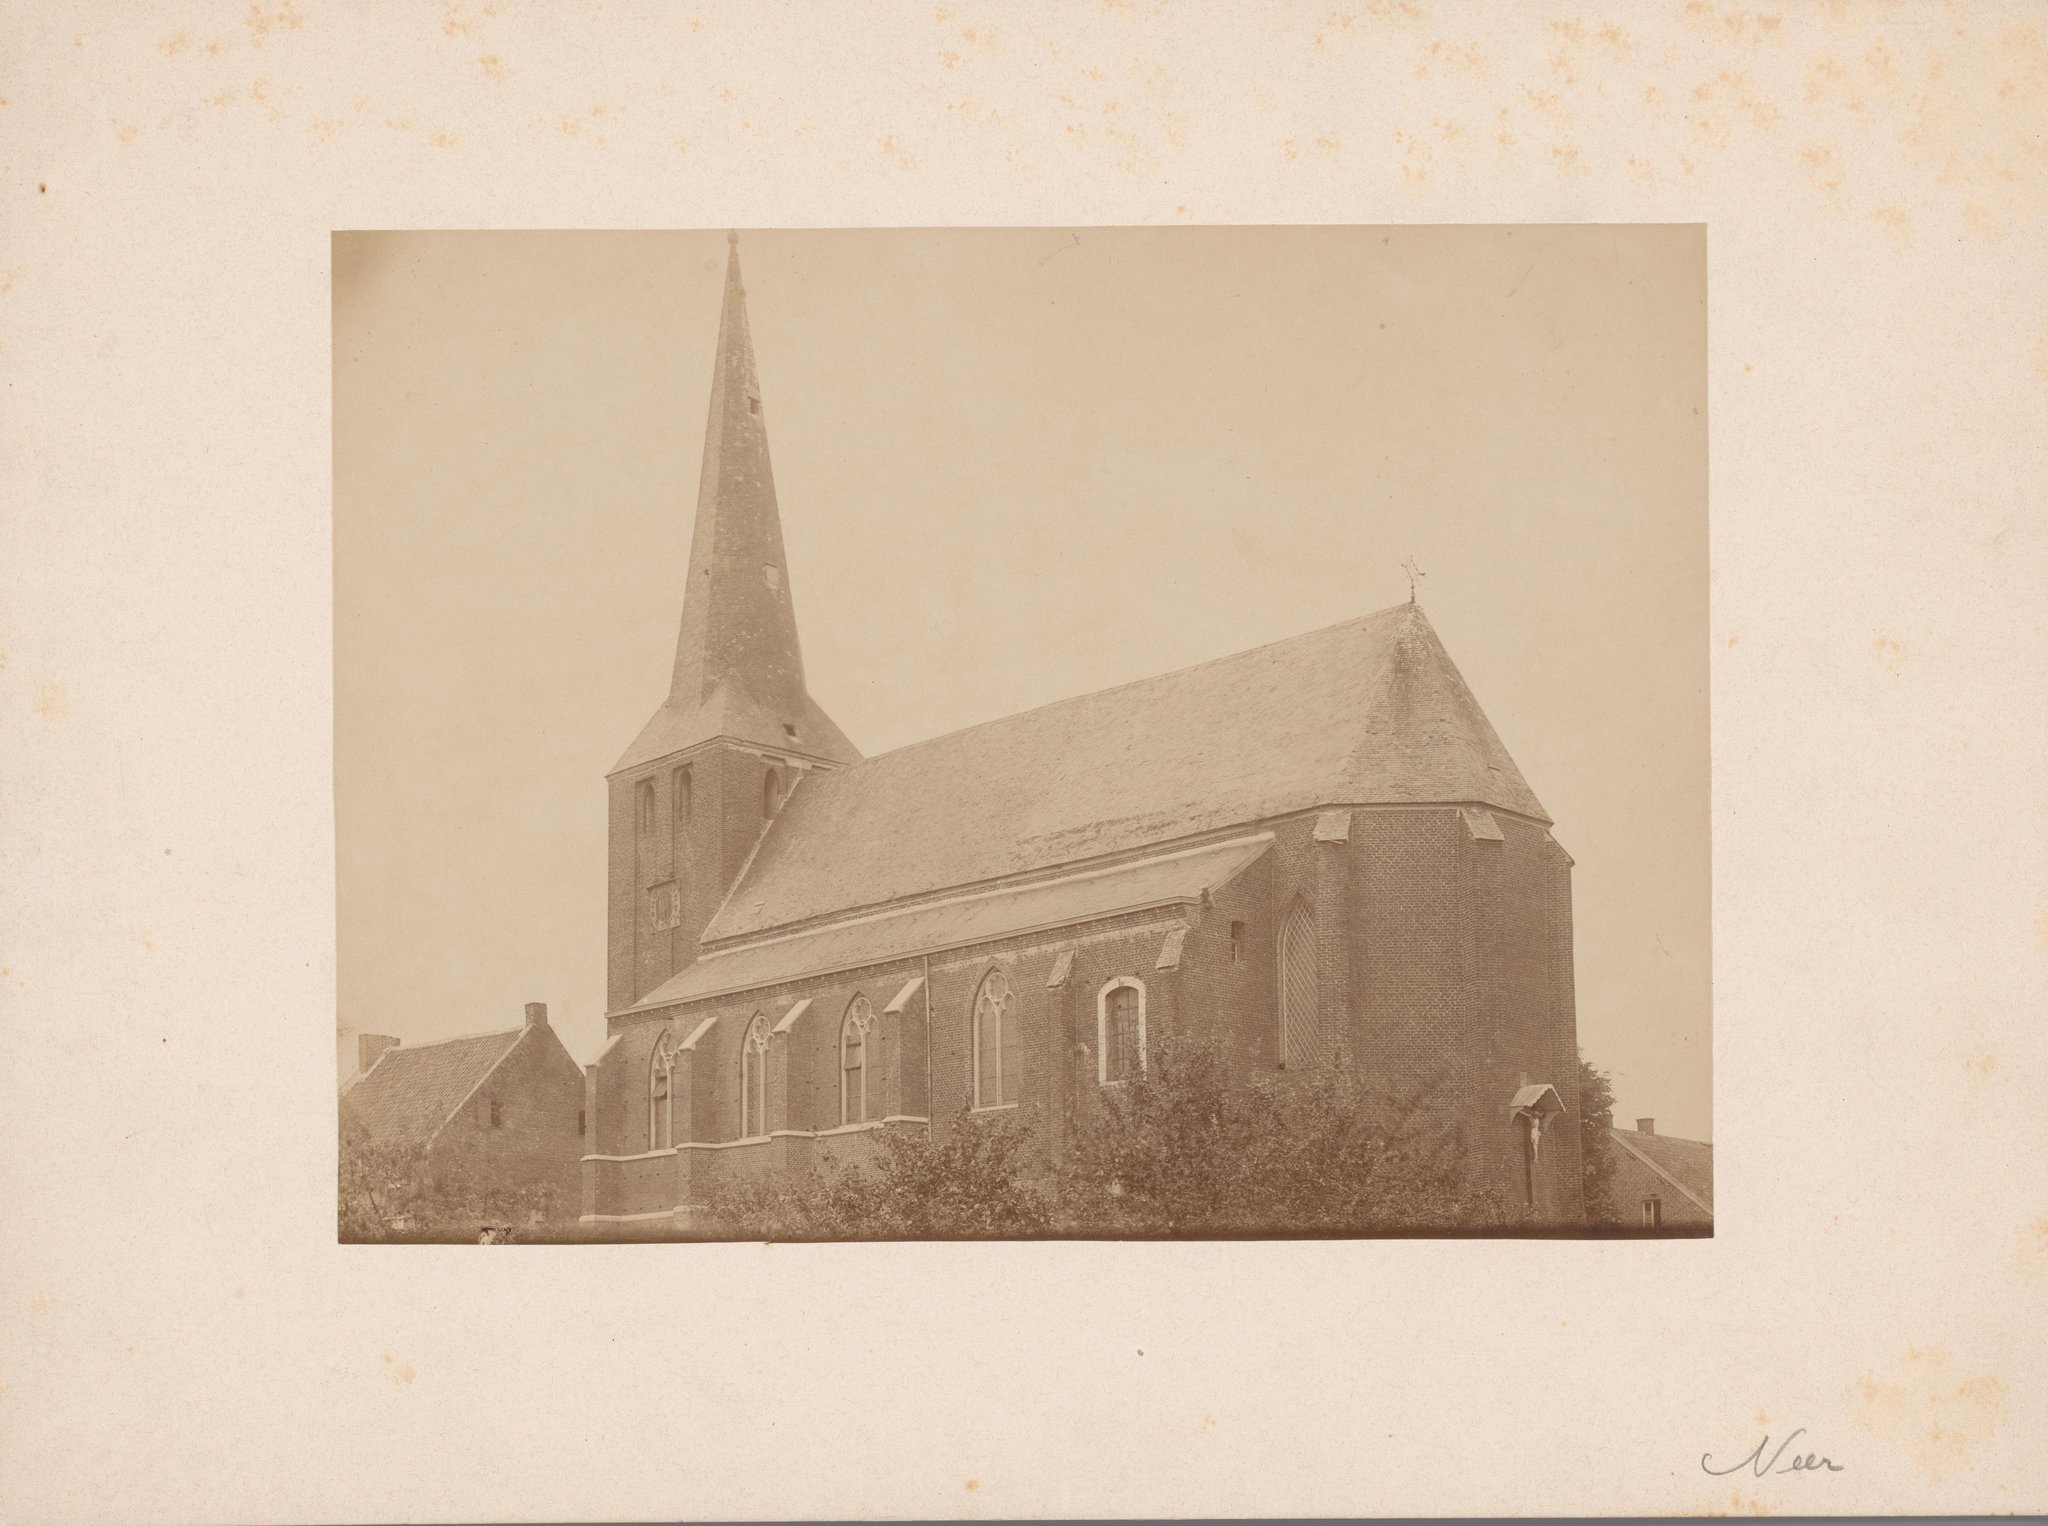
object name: photograph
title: Gezicht op de oude Sint-Martinuskerk te Neer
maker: anoniem (monumentenzorg)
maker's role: fotograaf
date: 1900-1910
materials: cardboard, photographic support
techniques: albumen print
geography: neer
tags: church (exterior)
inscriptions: annotation: ‘R.K. Kerk te Neer (L.)’, annotation: ‘Neer’